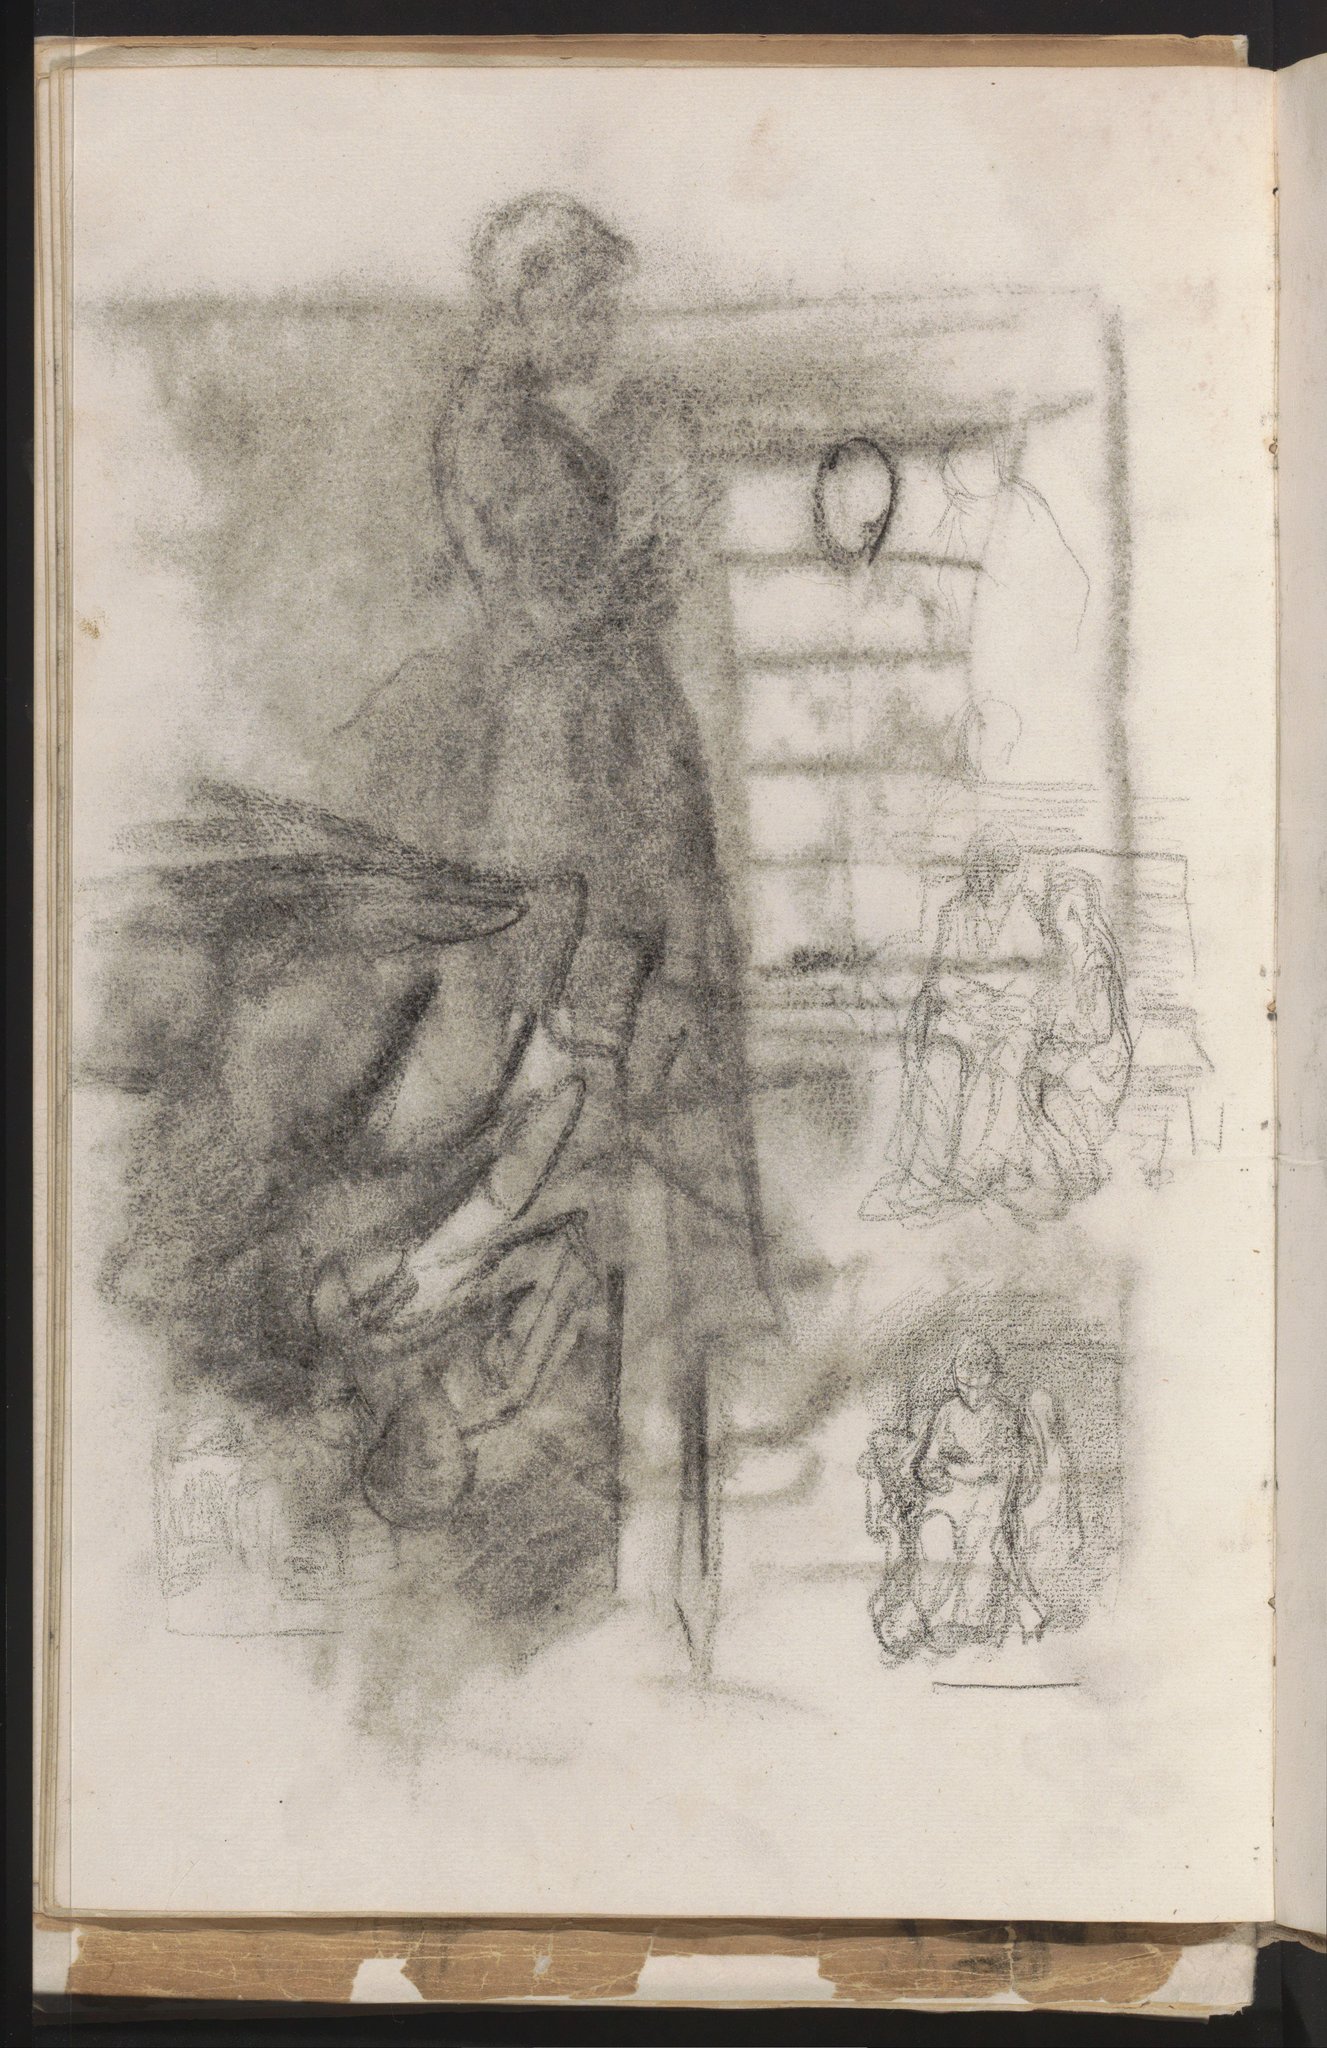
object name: sketchbook leaf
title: Studieblad met vrouwen en kinderen in interieurs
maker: albert neuhuys (1844-1914)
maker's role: draughtsman, painter, print maker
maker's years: 1844-1914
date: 1854-1914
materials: chalk, charcoal, paper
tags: sitting figure, adult woman, child, interior of the house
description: Blad 39 verso uit een schetsboek met 53 bladen.